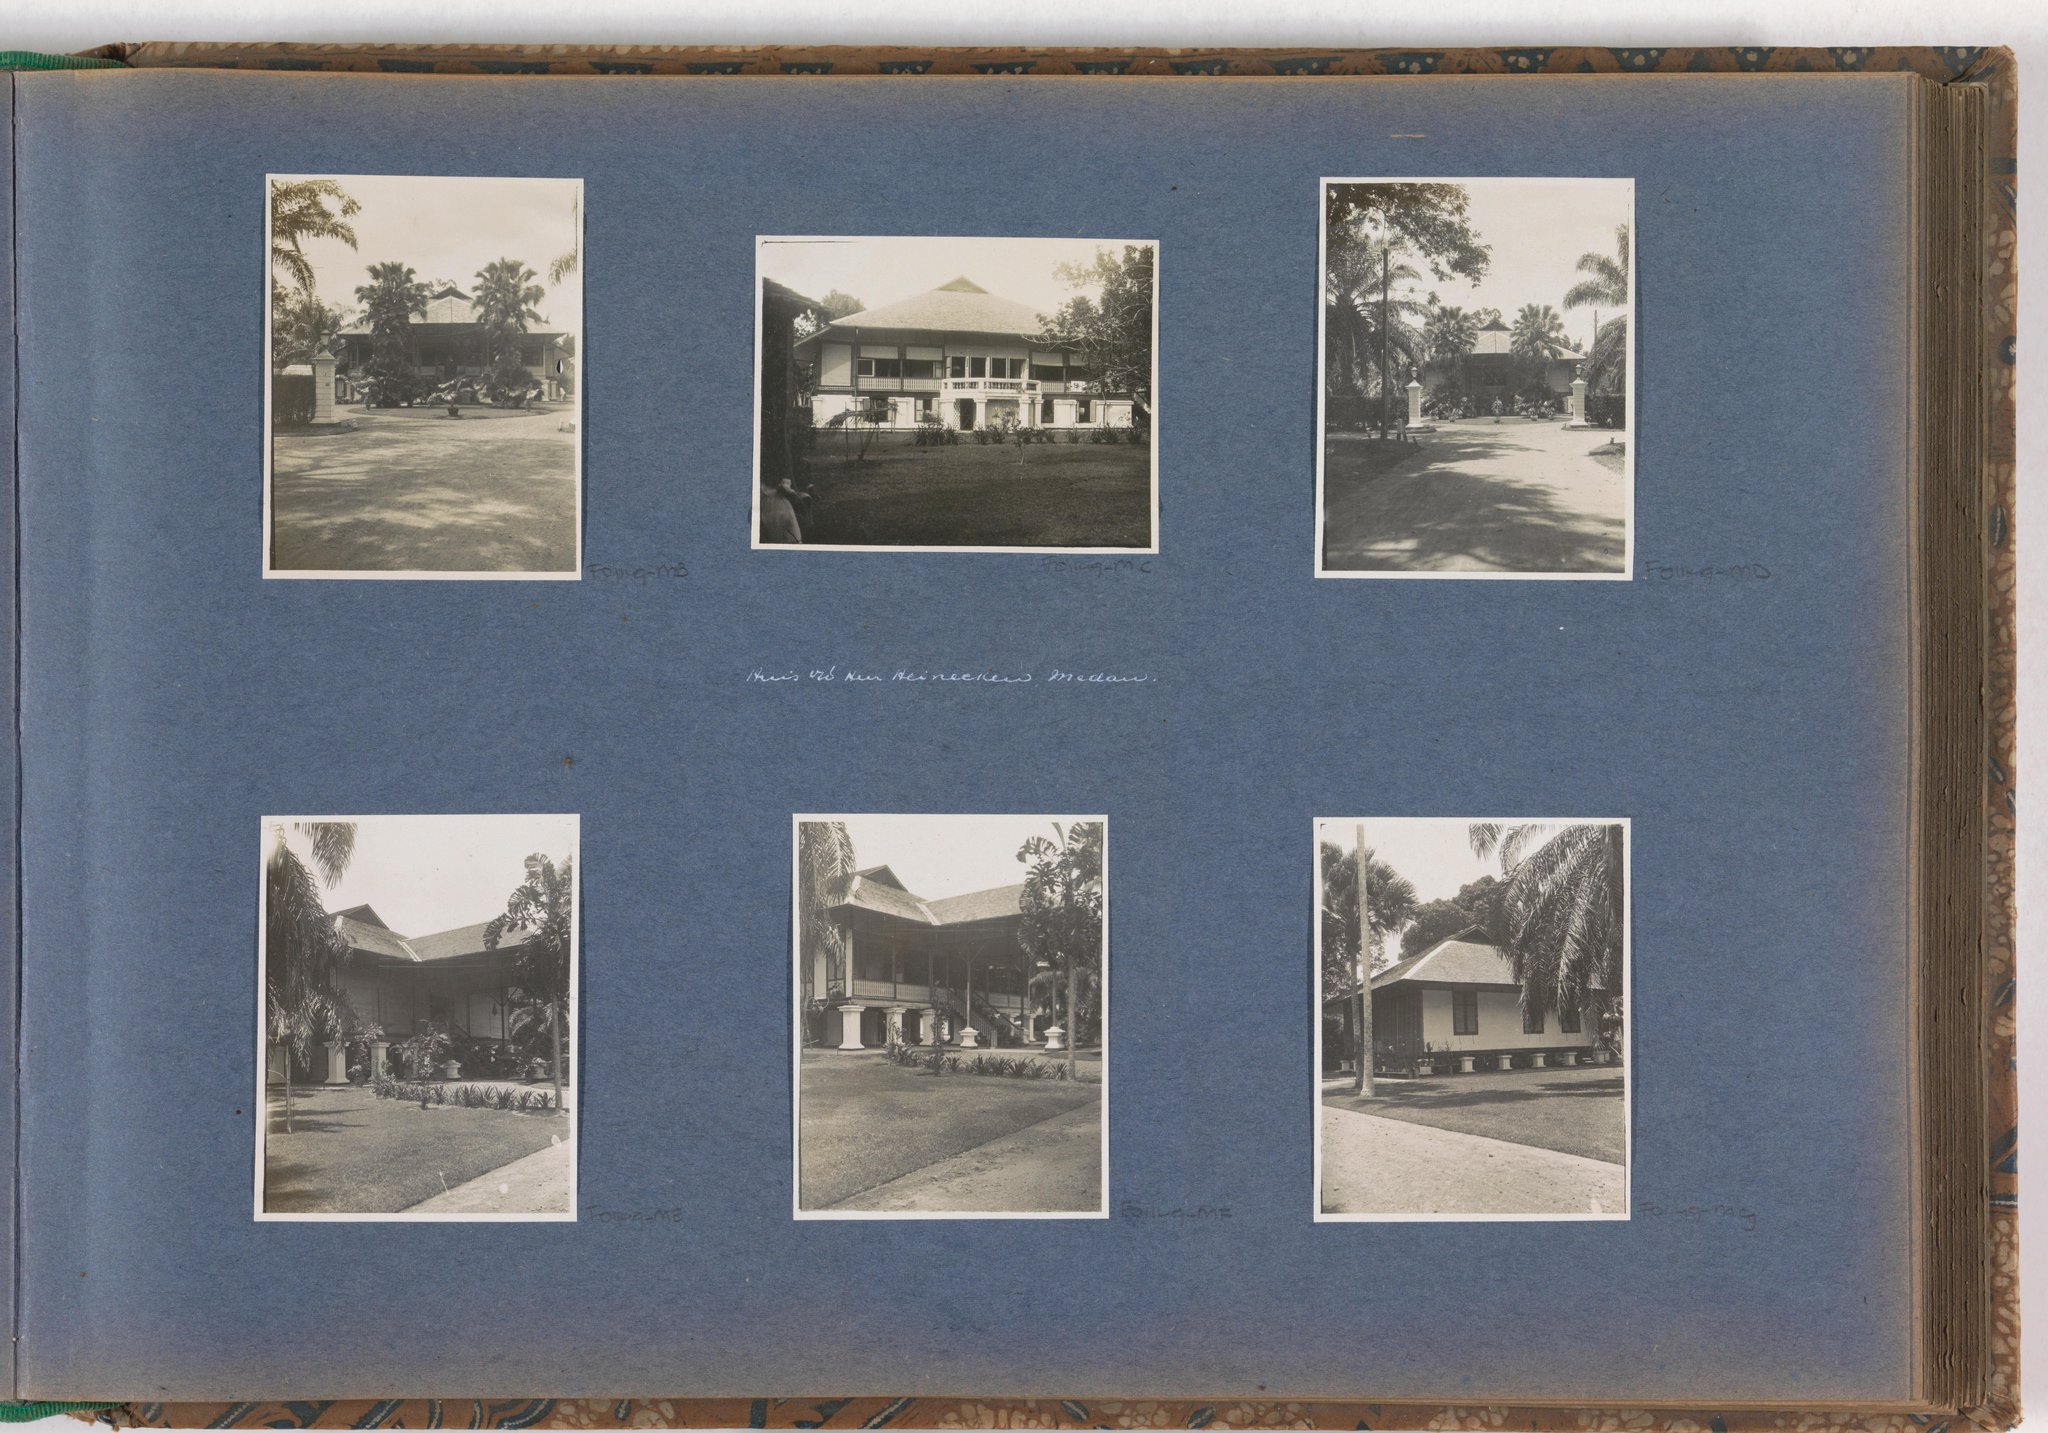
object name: photograph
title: Exterieur van het huis en de tuin van de heer Heinecken in Medan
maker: Anonymous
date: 1900-1920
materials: paper, photographic support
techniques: gelatin silver print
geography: medan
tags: garden, rural housing, e.g. country-house, villa, cottage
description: Onderdeel van reisalbum met foto's van bedrijvigheid en bezienswaardigheden op Sumatra en Java en van de reis naar en van Nederlands-Indië.